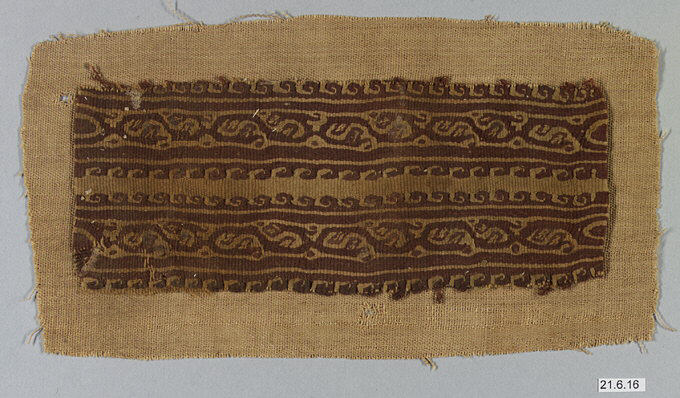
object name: band fragment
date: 301-500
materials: wool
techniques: tapestry, weave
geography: egypt